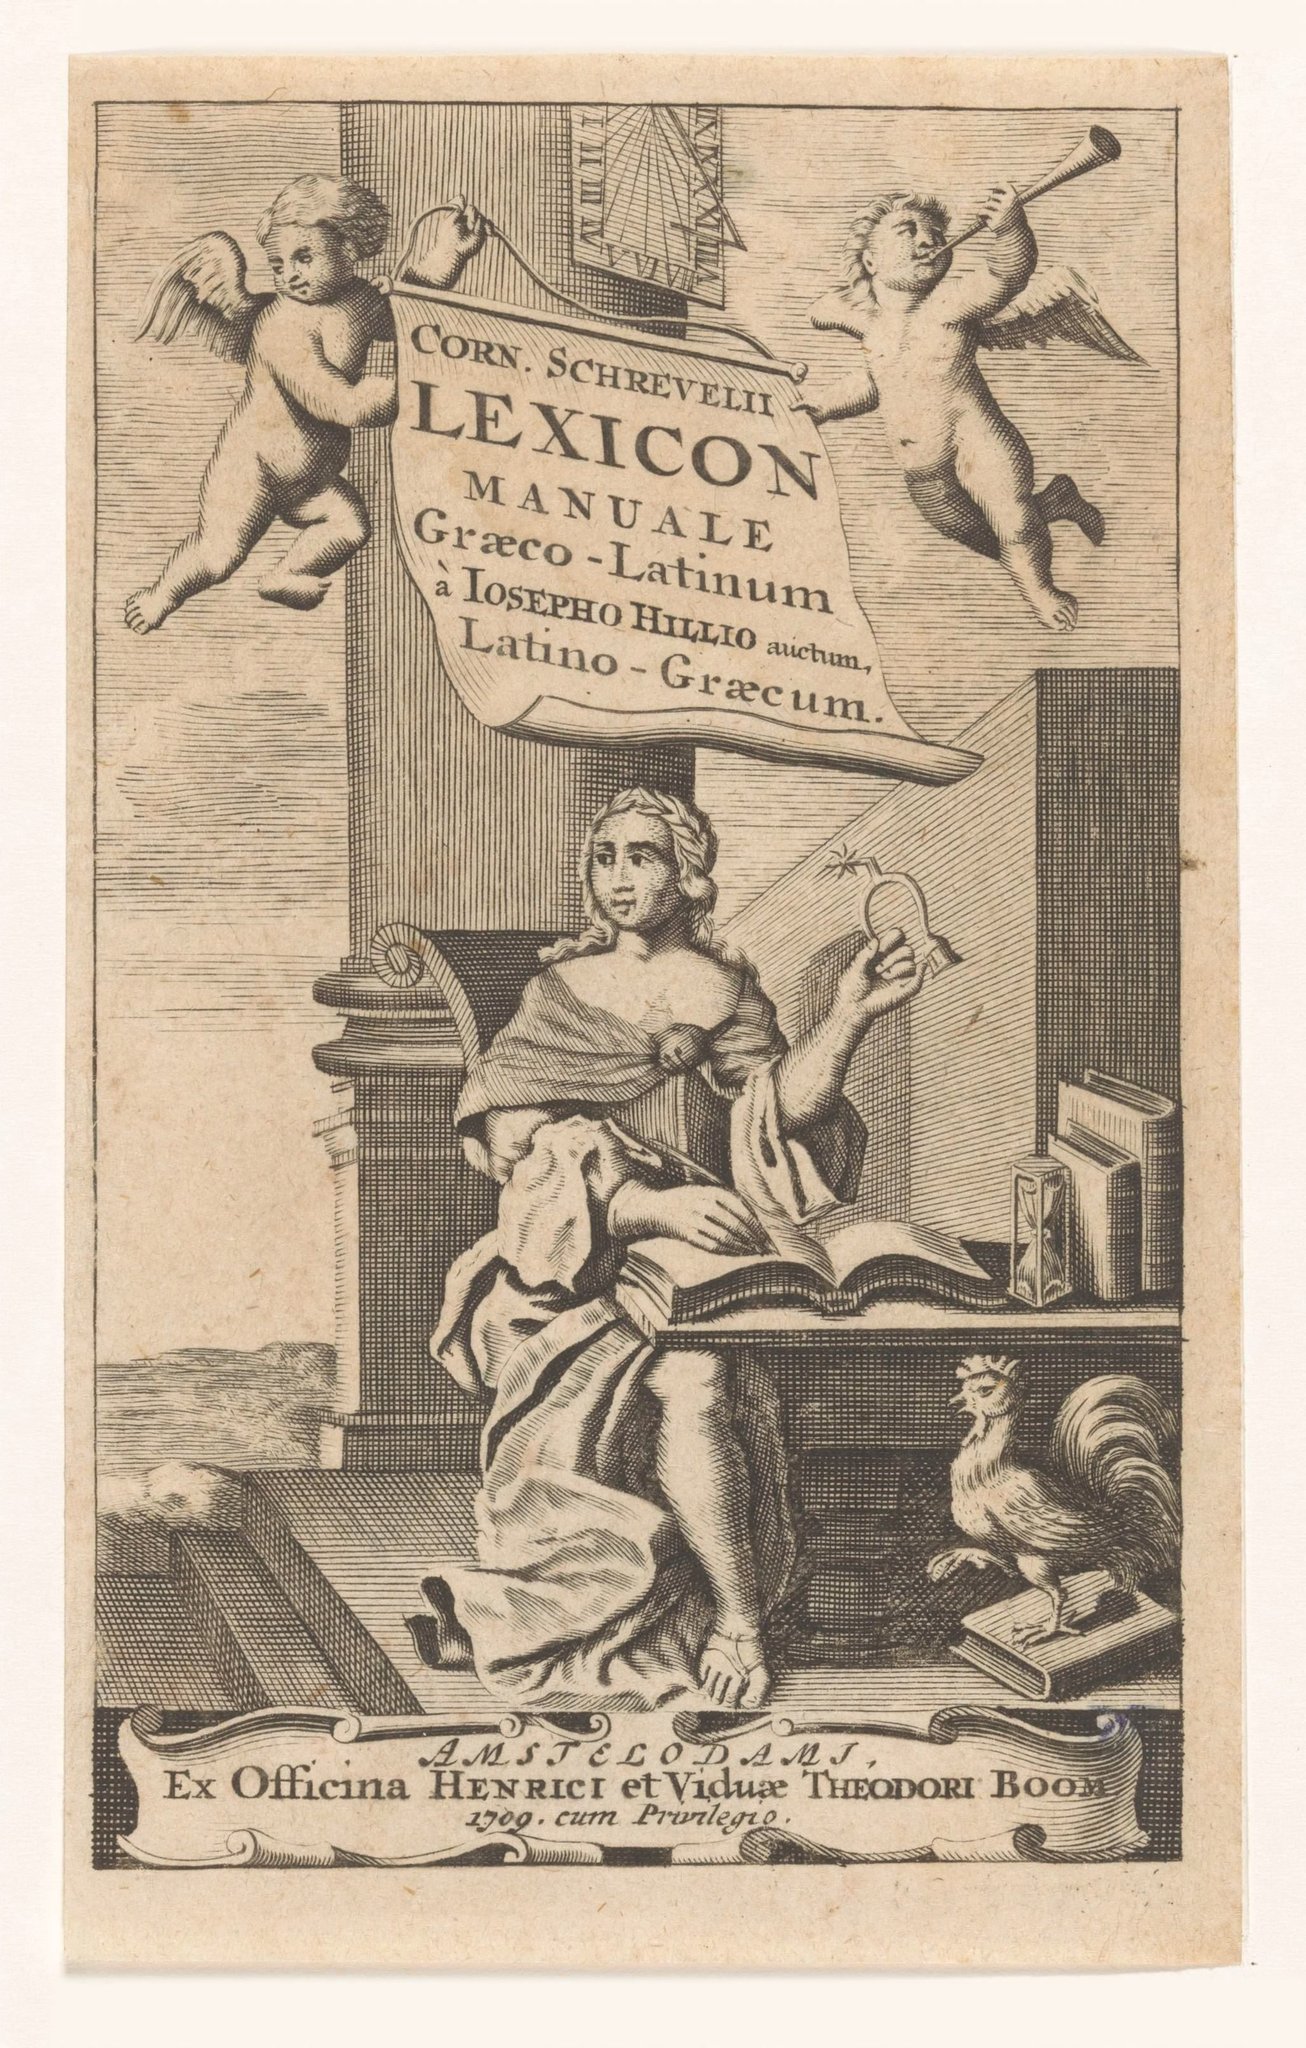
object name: titelblad, titelpagina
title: Titelpagina voor: Schrevel, Cornelis. Lexicon Manuale Graeco-Latinum, 1709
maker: Anonymous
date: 1709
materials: paper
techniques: engraving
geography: amsterdam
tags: writing-table, writing-desk, book, hourglass, spur, sundial, cupids: 'amores', 'amoretti', 'putti'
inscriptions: collector's mark: Lugt 2228, collector's mark: Lugt 4779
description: Een schrijvende man achter een tafel met sporen in zijn hand, op de tafel een zandloper en boeken, op de voorgrond een haan op een boek. Achter de man een pilaar met een zonnewijzer en boven zijn hoofd twee putti met banderole.